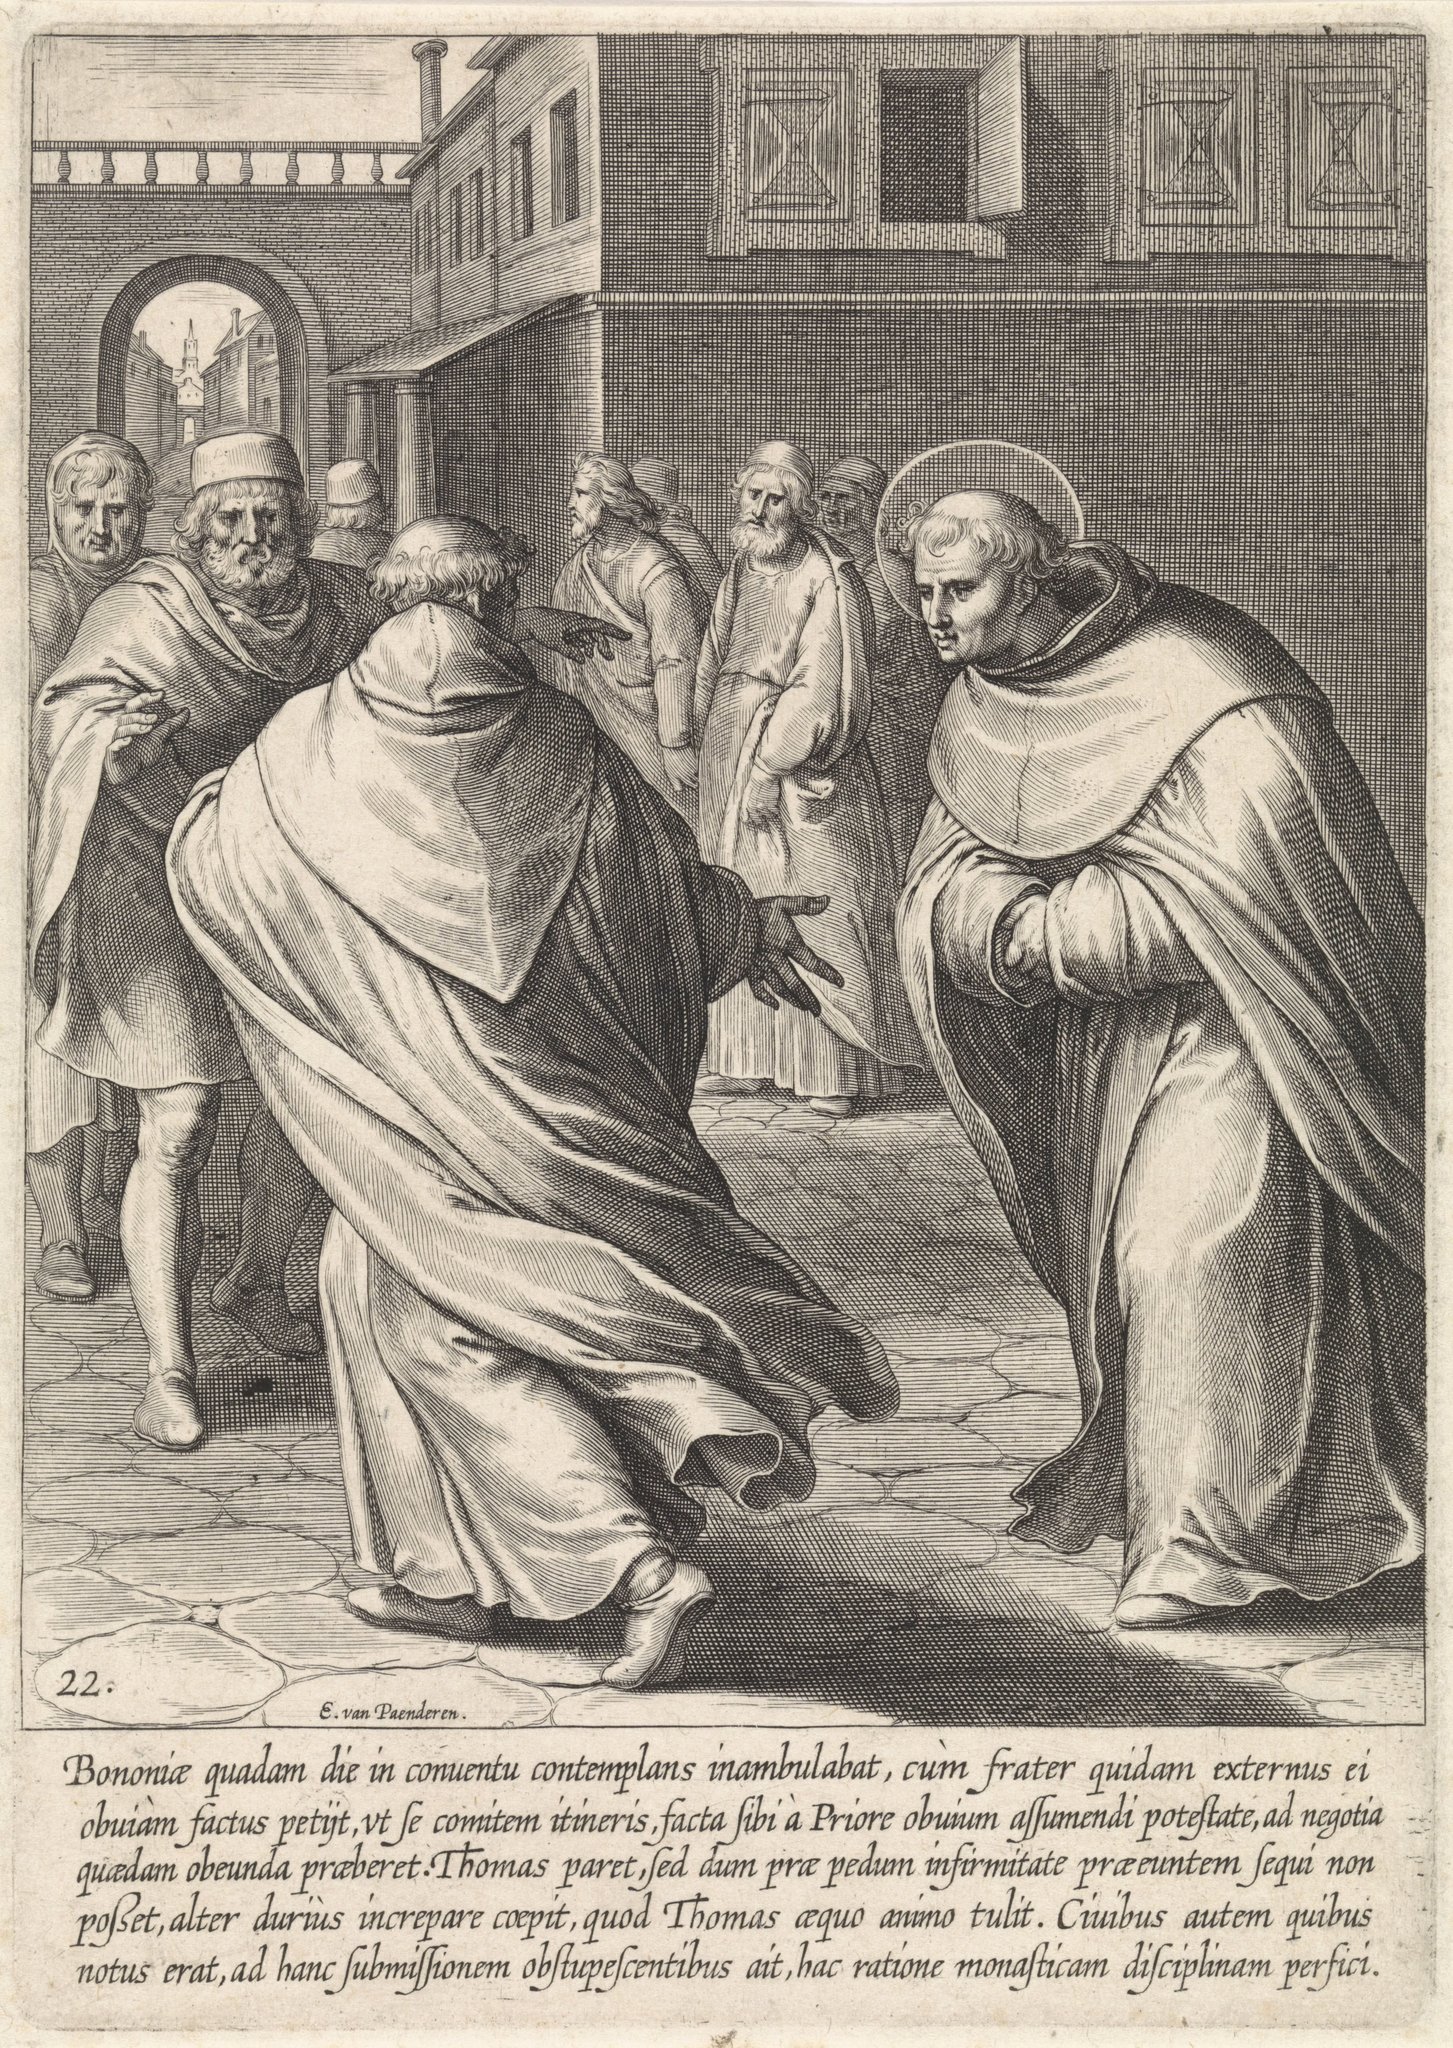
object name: print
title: Het leven van de heilige Thomas van Aquino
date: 1610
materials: paper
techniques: engraving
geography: antwerp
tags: the dominican theologian, 'angelic doctor' thomas of aquino; possible attributes: book, (chain with) sun, dove, girdle of chastity, lily, model of church, monstrance (or chalice), mitre (under feet), star (on breast) - early life of male saint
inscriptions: collector's mark: Lugt 2228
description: Thomas van Aquino ontmoet een monnik in een kloostertuin in Bologna. Diverse figuren kijken toe. In de marge een vijfregelig onderschrift in het Latijn. Tweeëntwingtigste prent uit een serie van dertig prenten die het levensverhaal van Thomas van Aquino verbeelden.